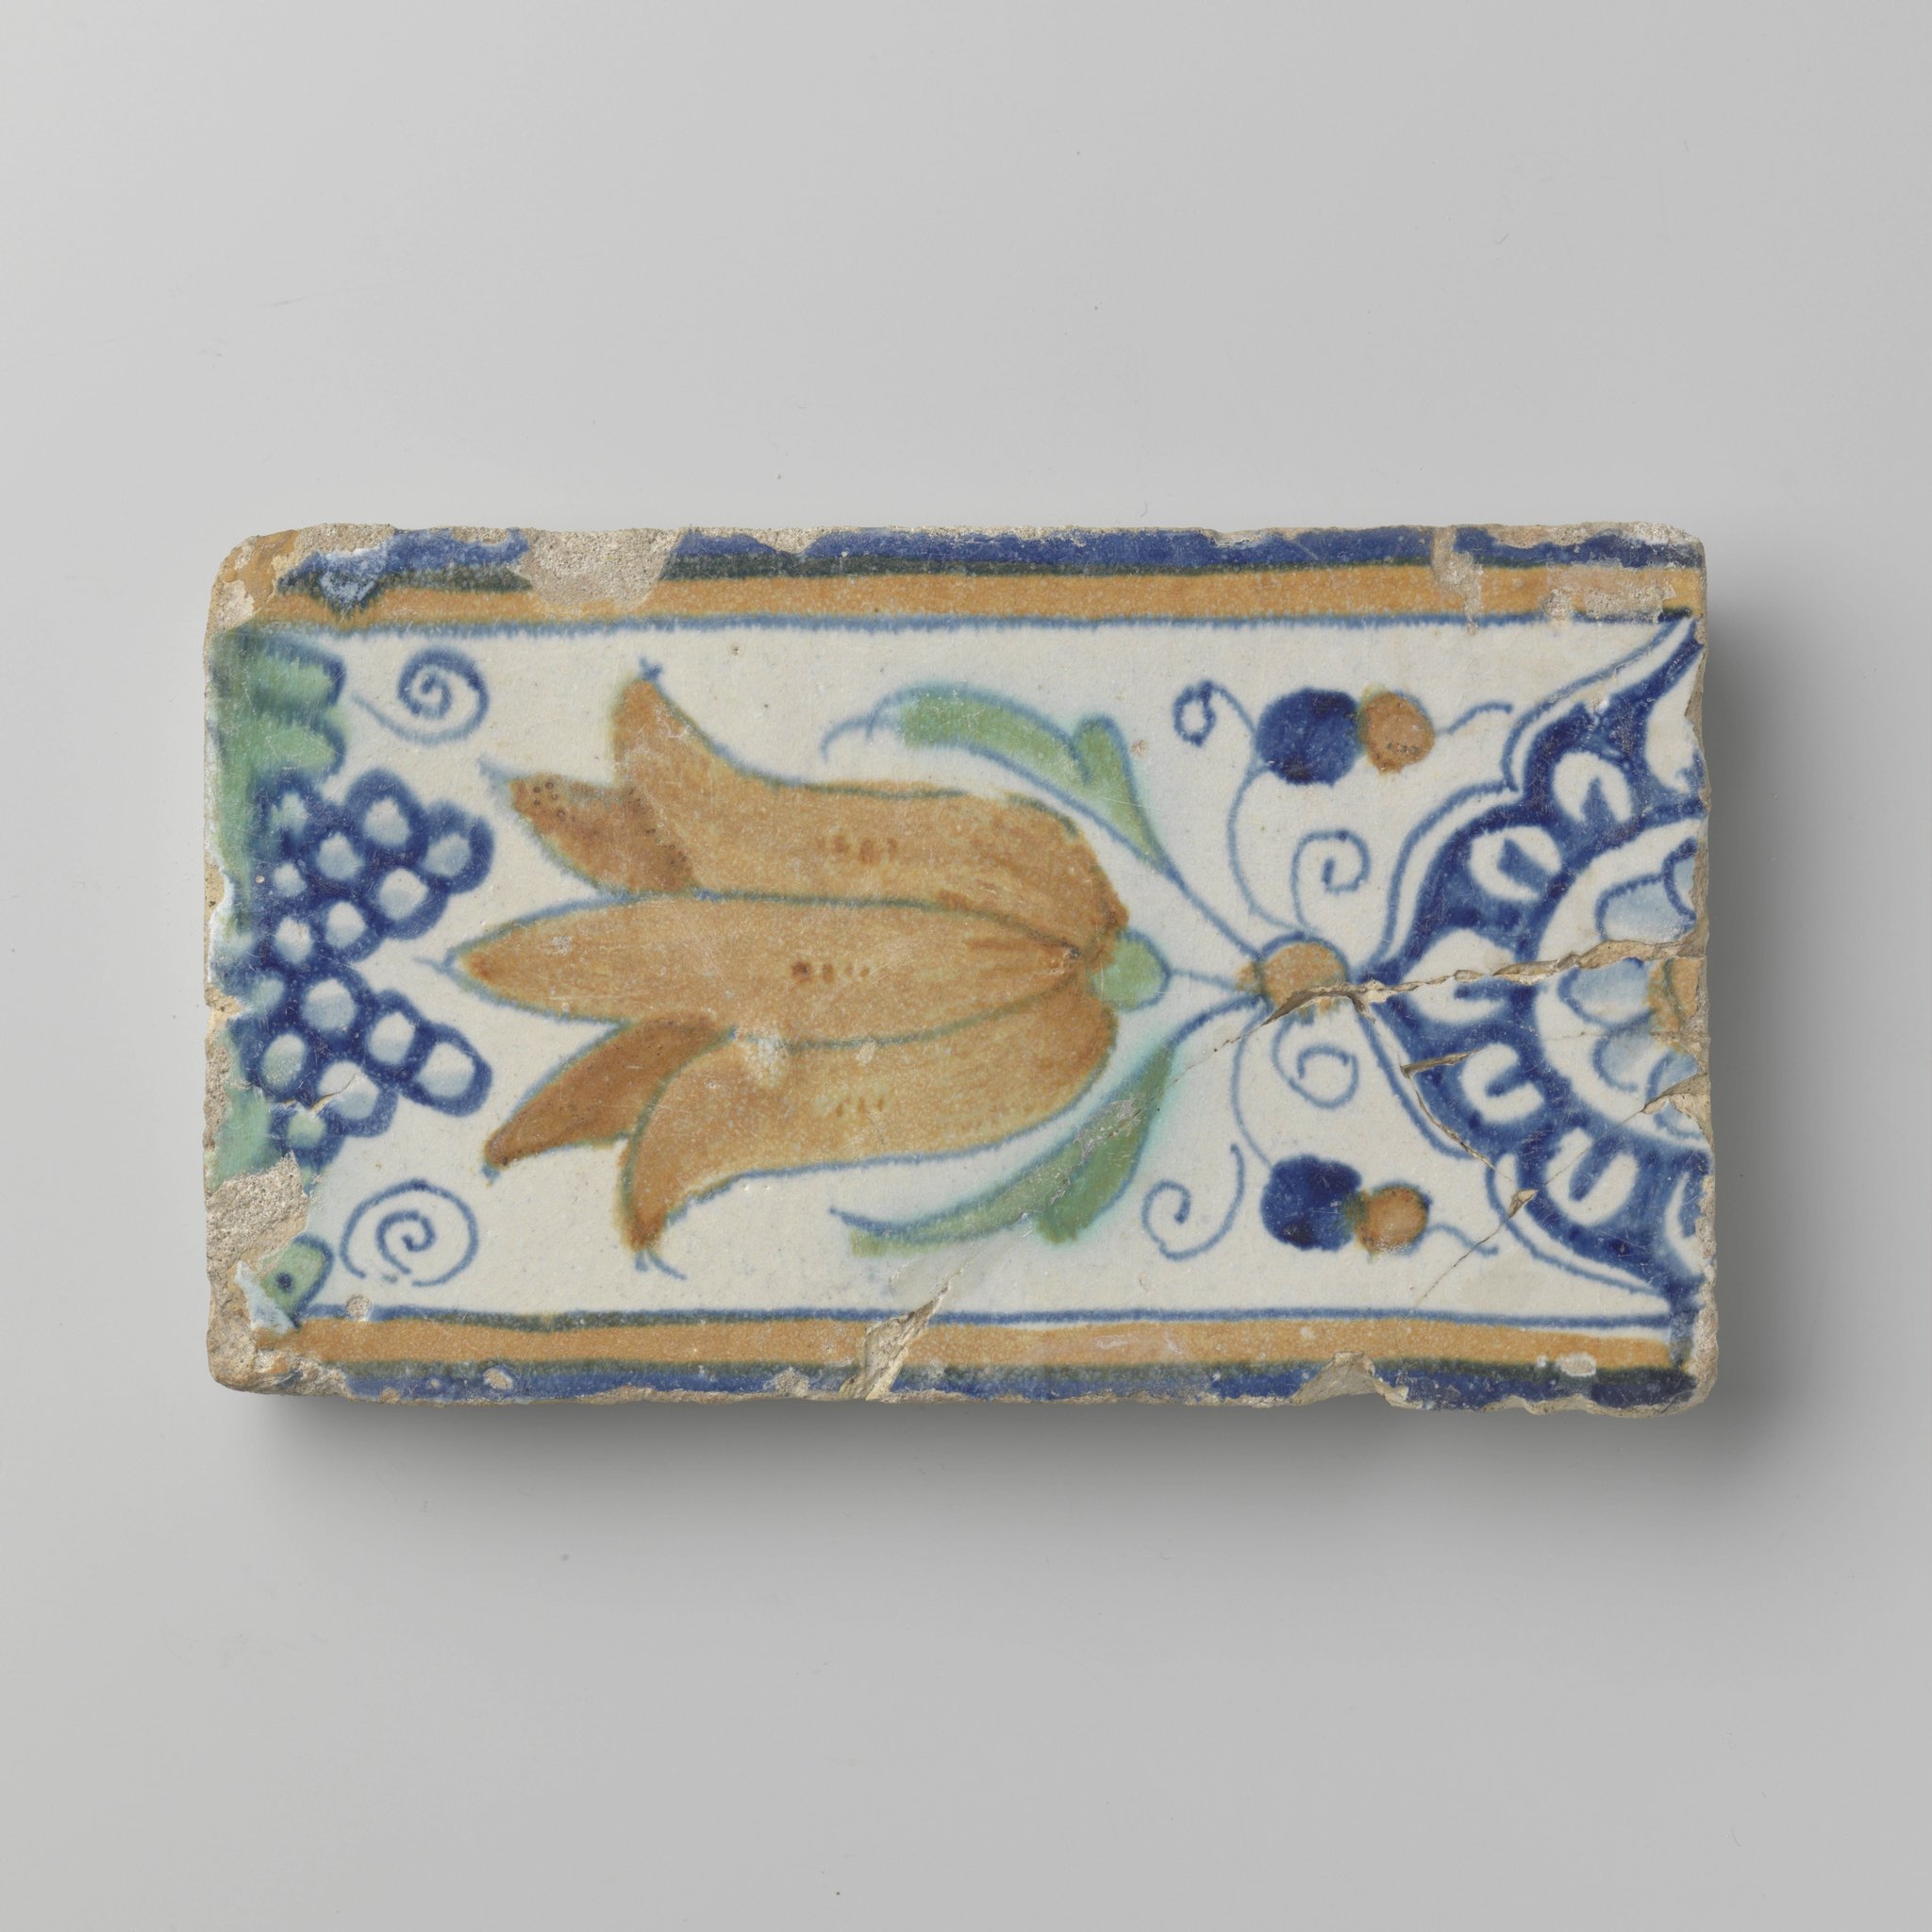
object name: randtegel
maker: Anonymous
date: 1600-1630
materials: earthenware, glaze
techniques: maiolica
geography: netherlands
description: Randtegel met een veelkleurige (blauw, groen en oranje) tulp tussen een rozetmotief en een druiventros.